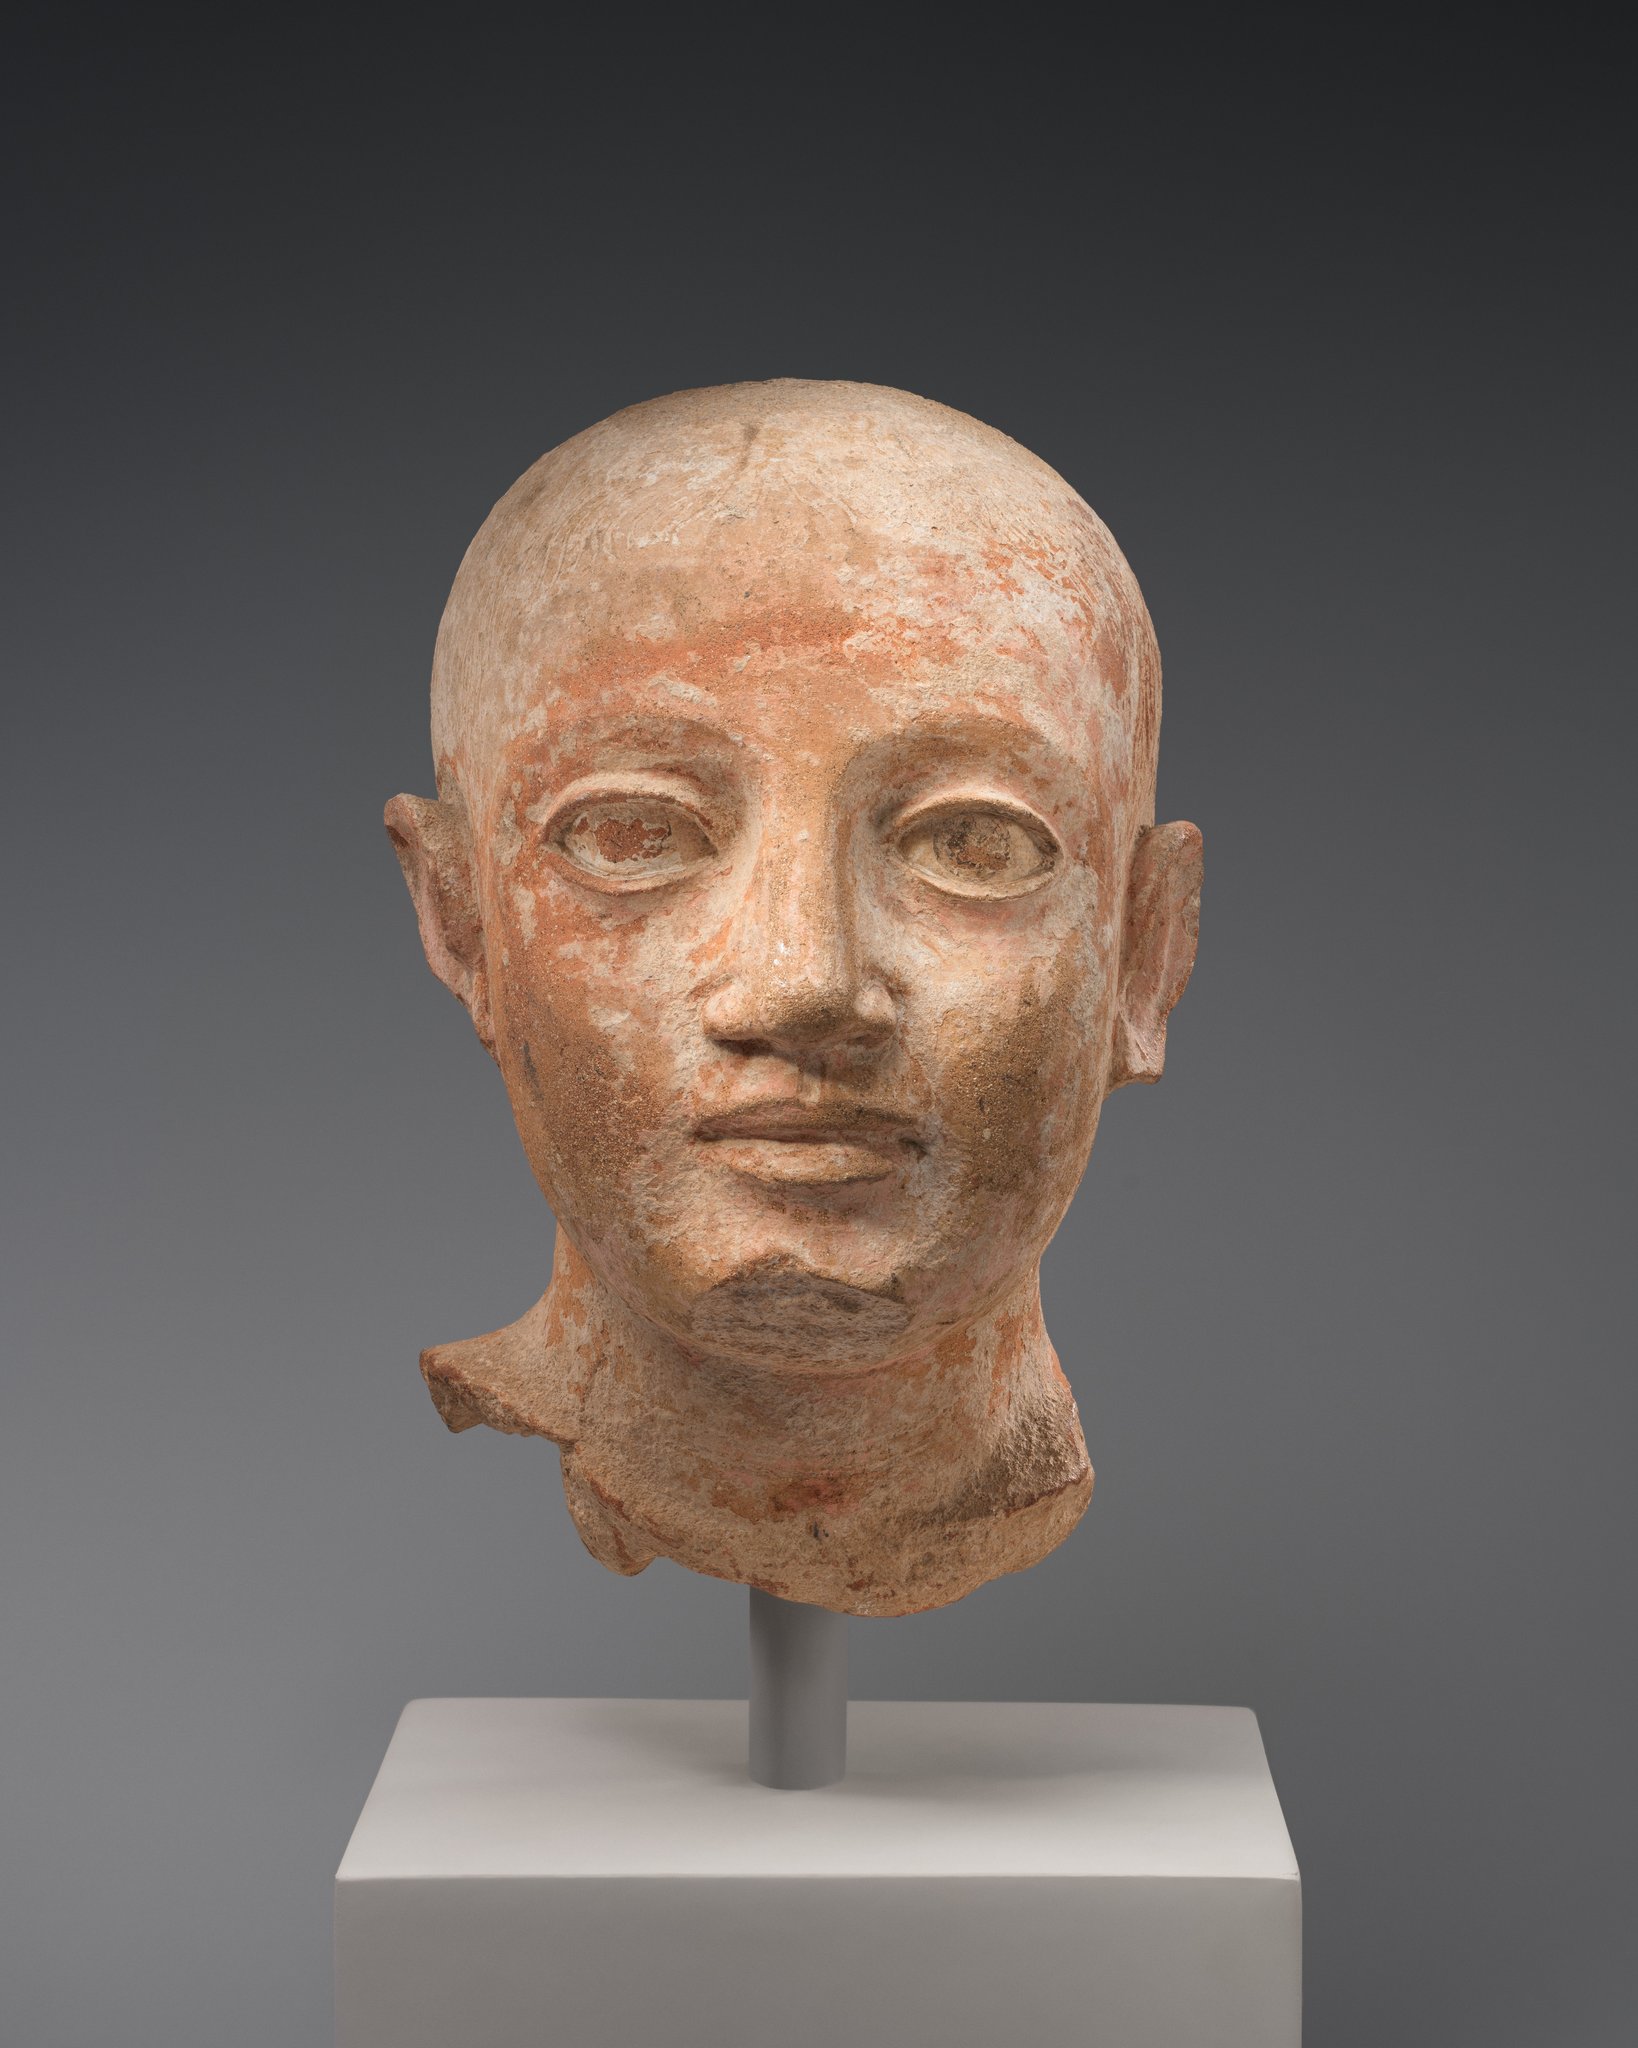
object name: head of a man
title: Terracotta head of a boy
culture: cypriot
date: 325-300 BCE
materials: terracotta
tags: heads,boys